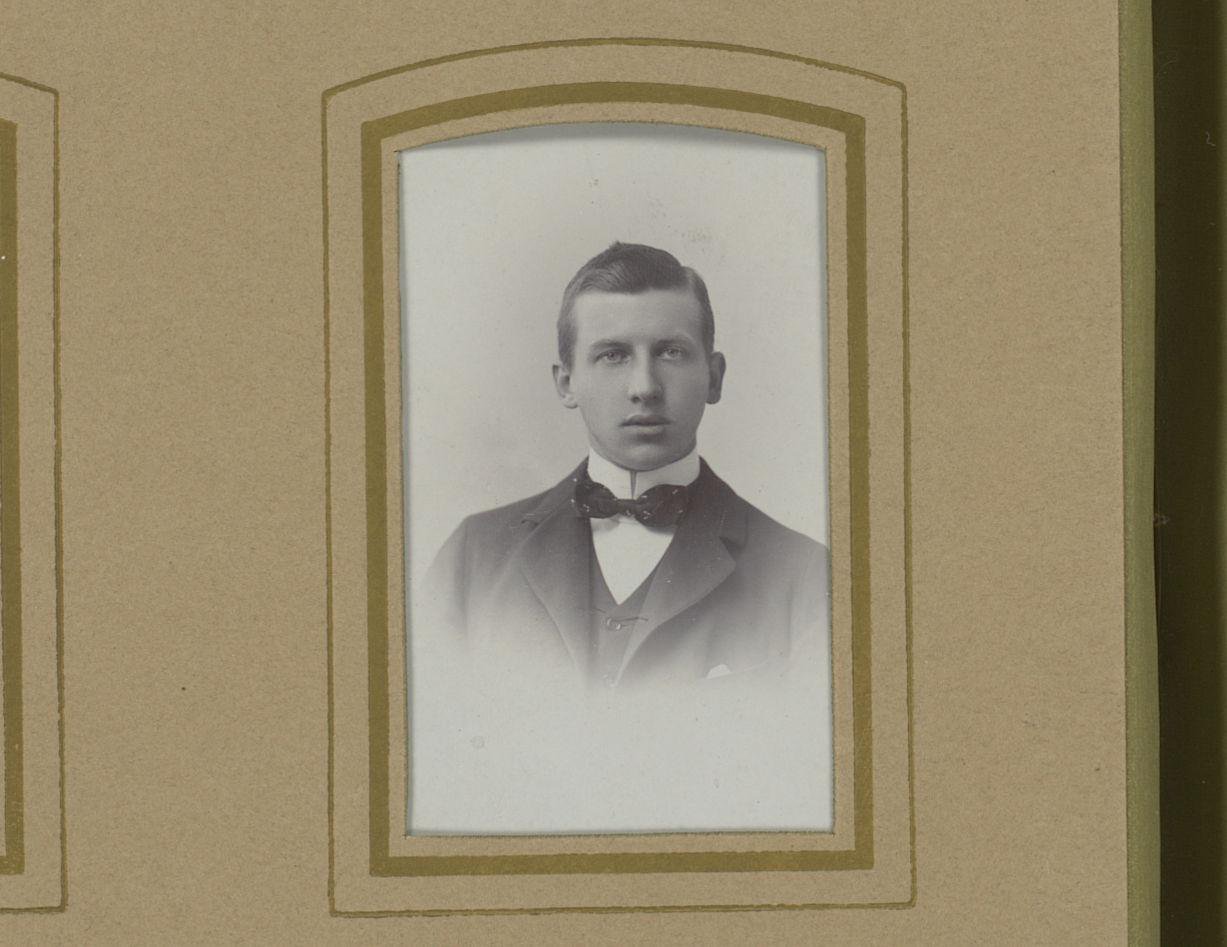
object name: album leaf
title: Portret van een jonge man met vlinderstrik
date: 1887-1920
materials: cardboard, photographic support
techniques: matte daylight collodion silver print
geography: netherlands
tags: historical persons, youth, adolescent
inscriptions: inscription: ‘[...] Batavia.’